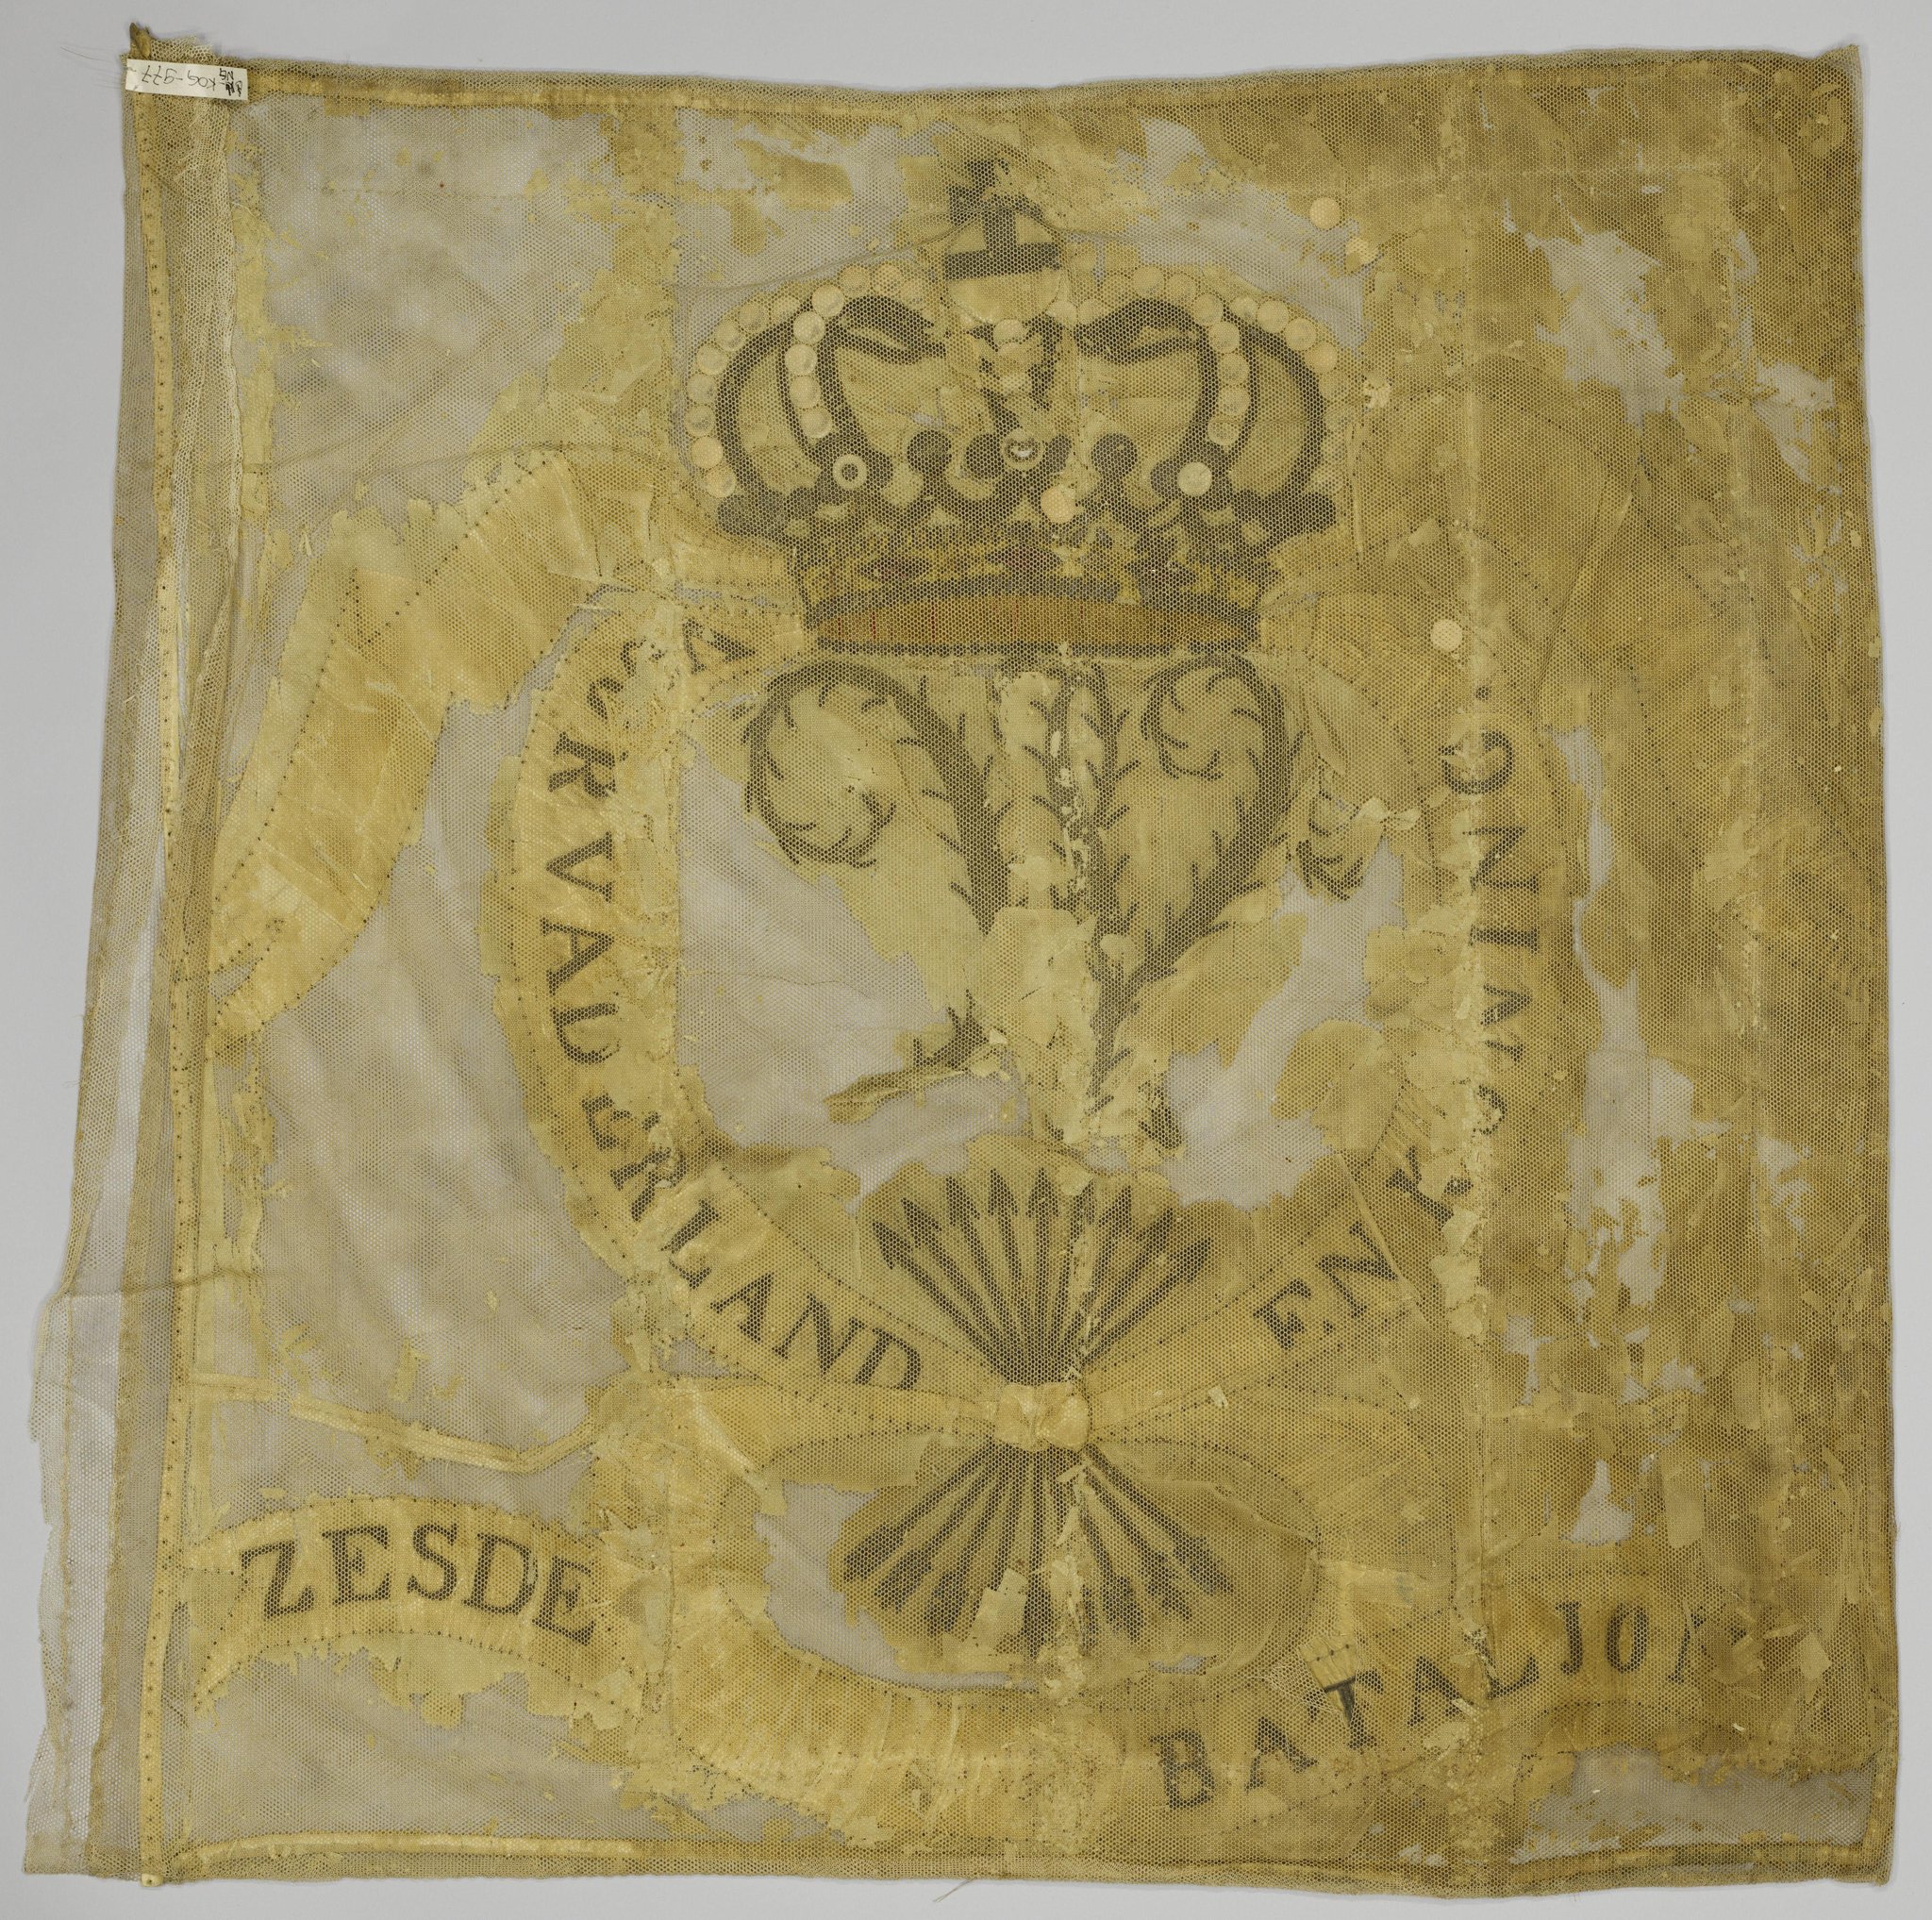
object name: banner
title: Vaandel van het zesde bataljon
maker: Anonymous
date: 1839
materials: gold thread, silk, thread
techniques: embroidered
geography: netherlands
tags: amsterdam